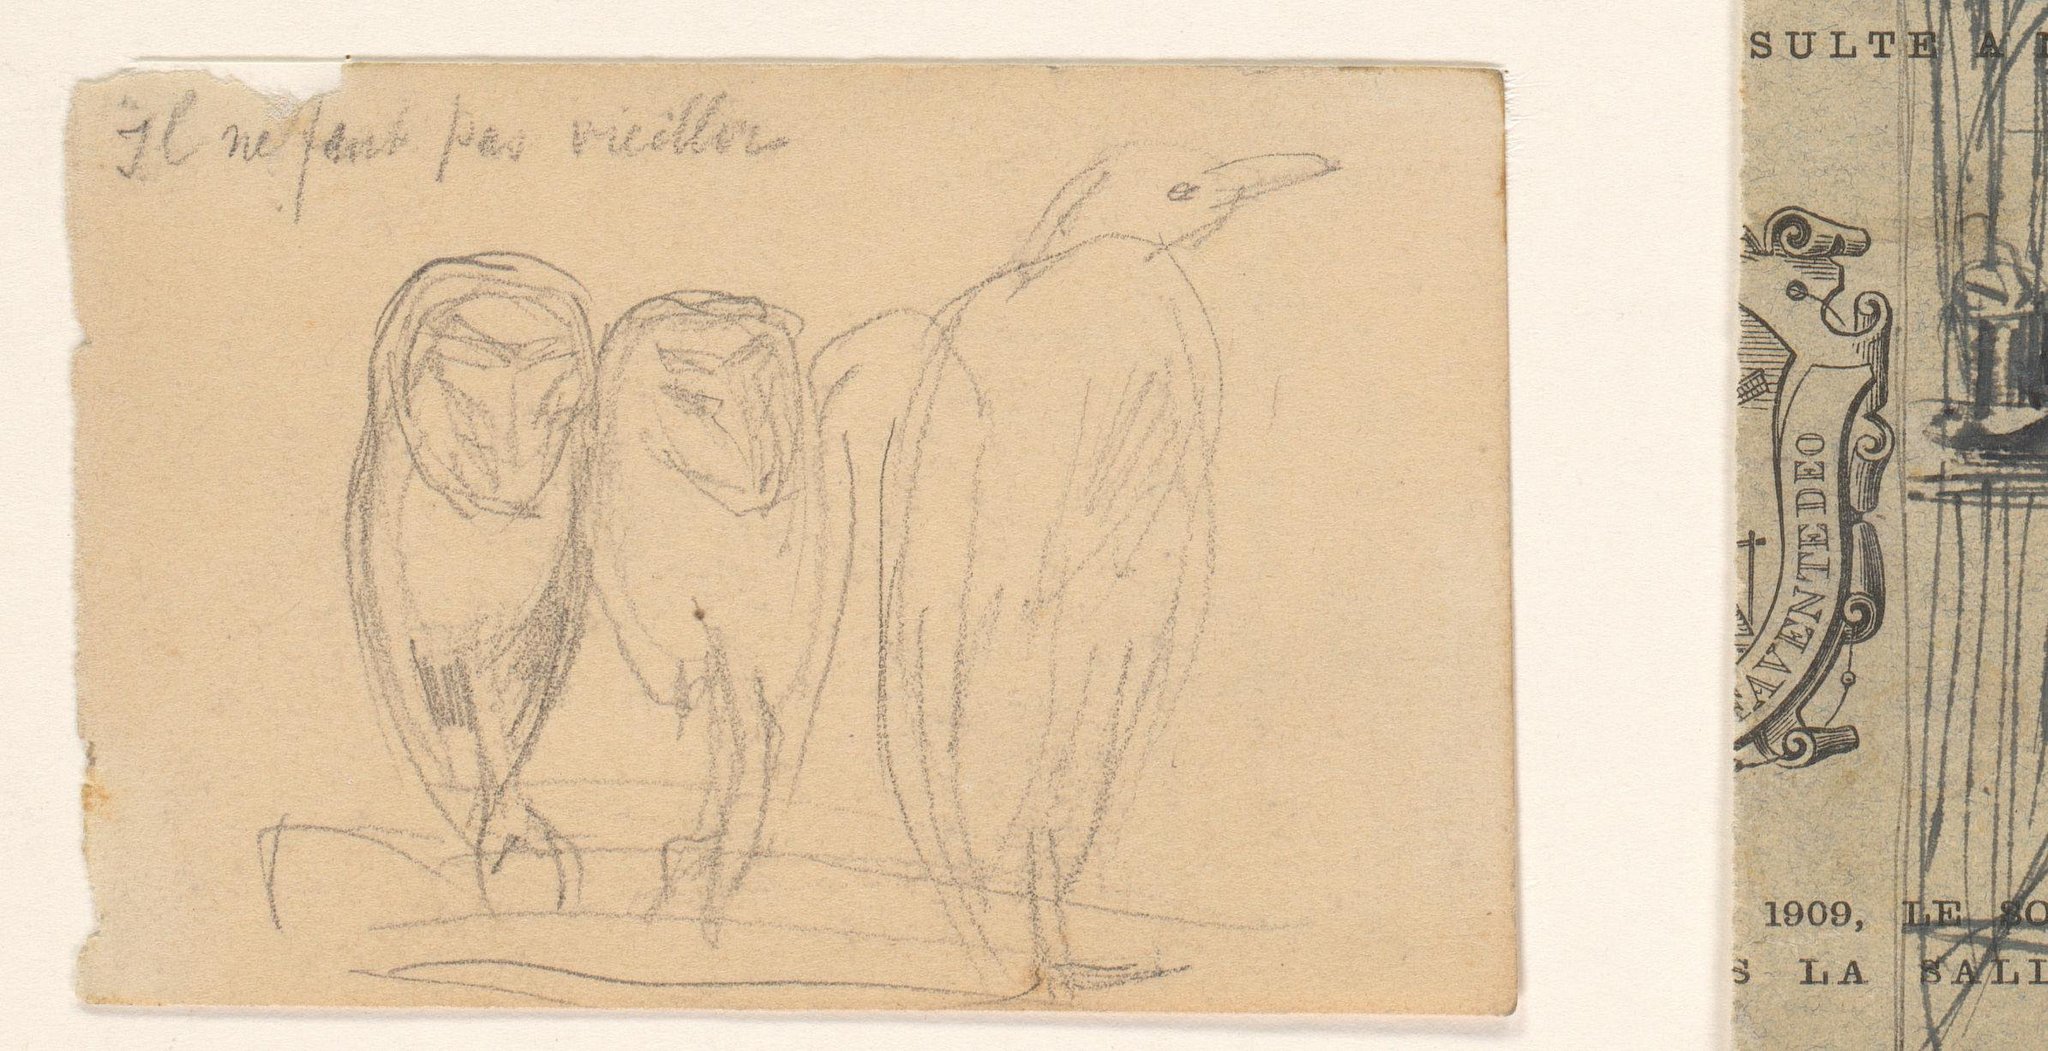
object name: drawing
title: Schetsblad met twee uilen en een andere vogel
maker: august allebé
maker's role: draughtsman, print maker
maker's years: 1838-1927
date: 1848-1927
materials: paper, pencil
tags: owls